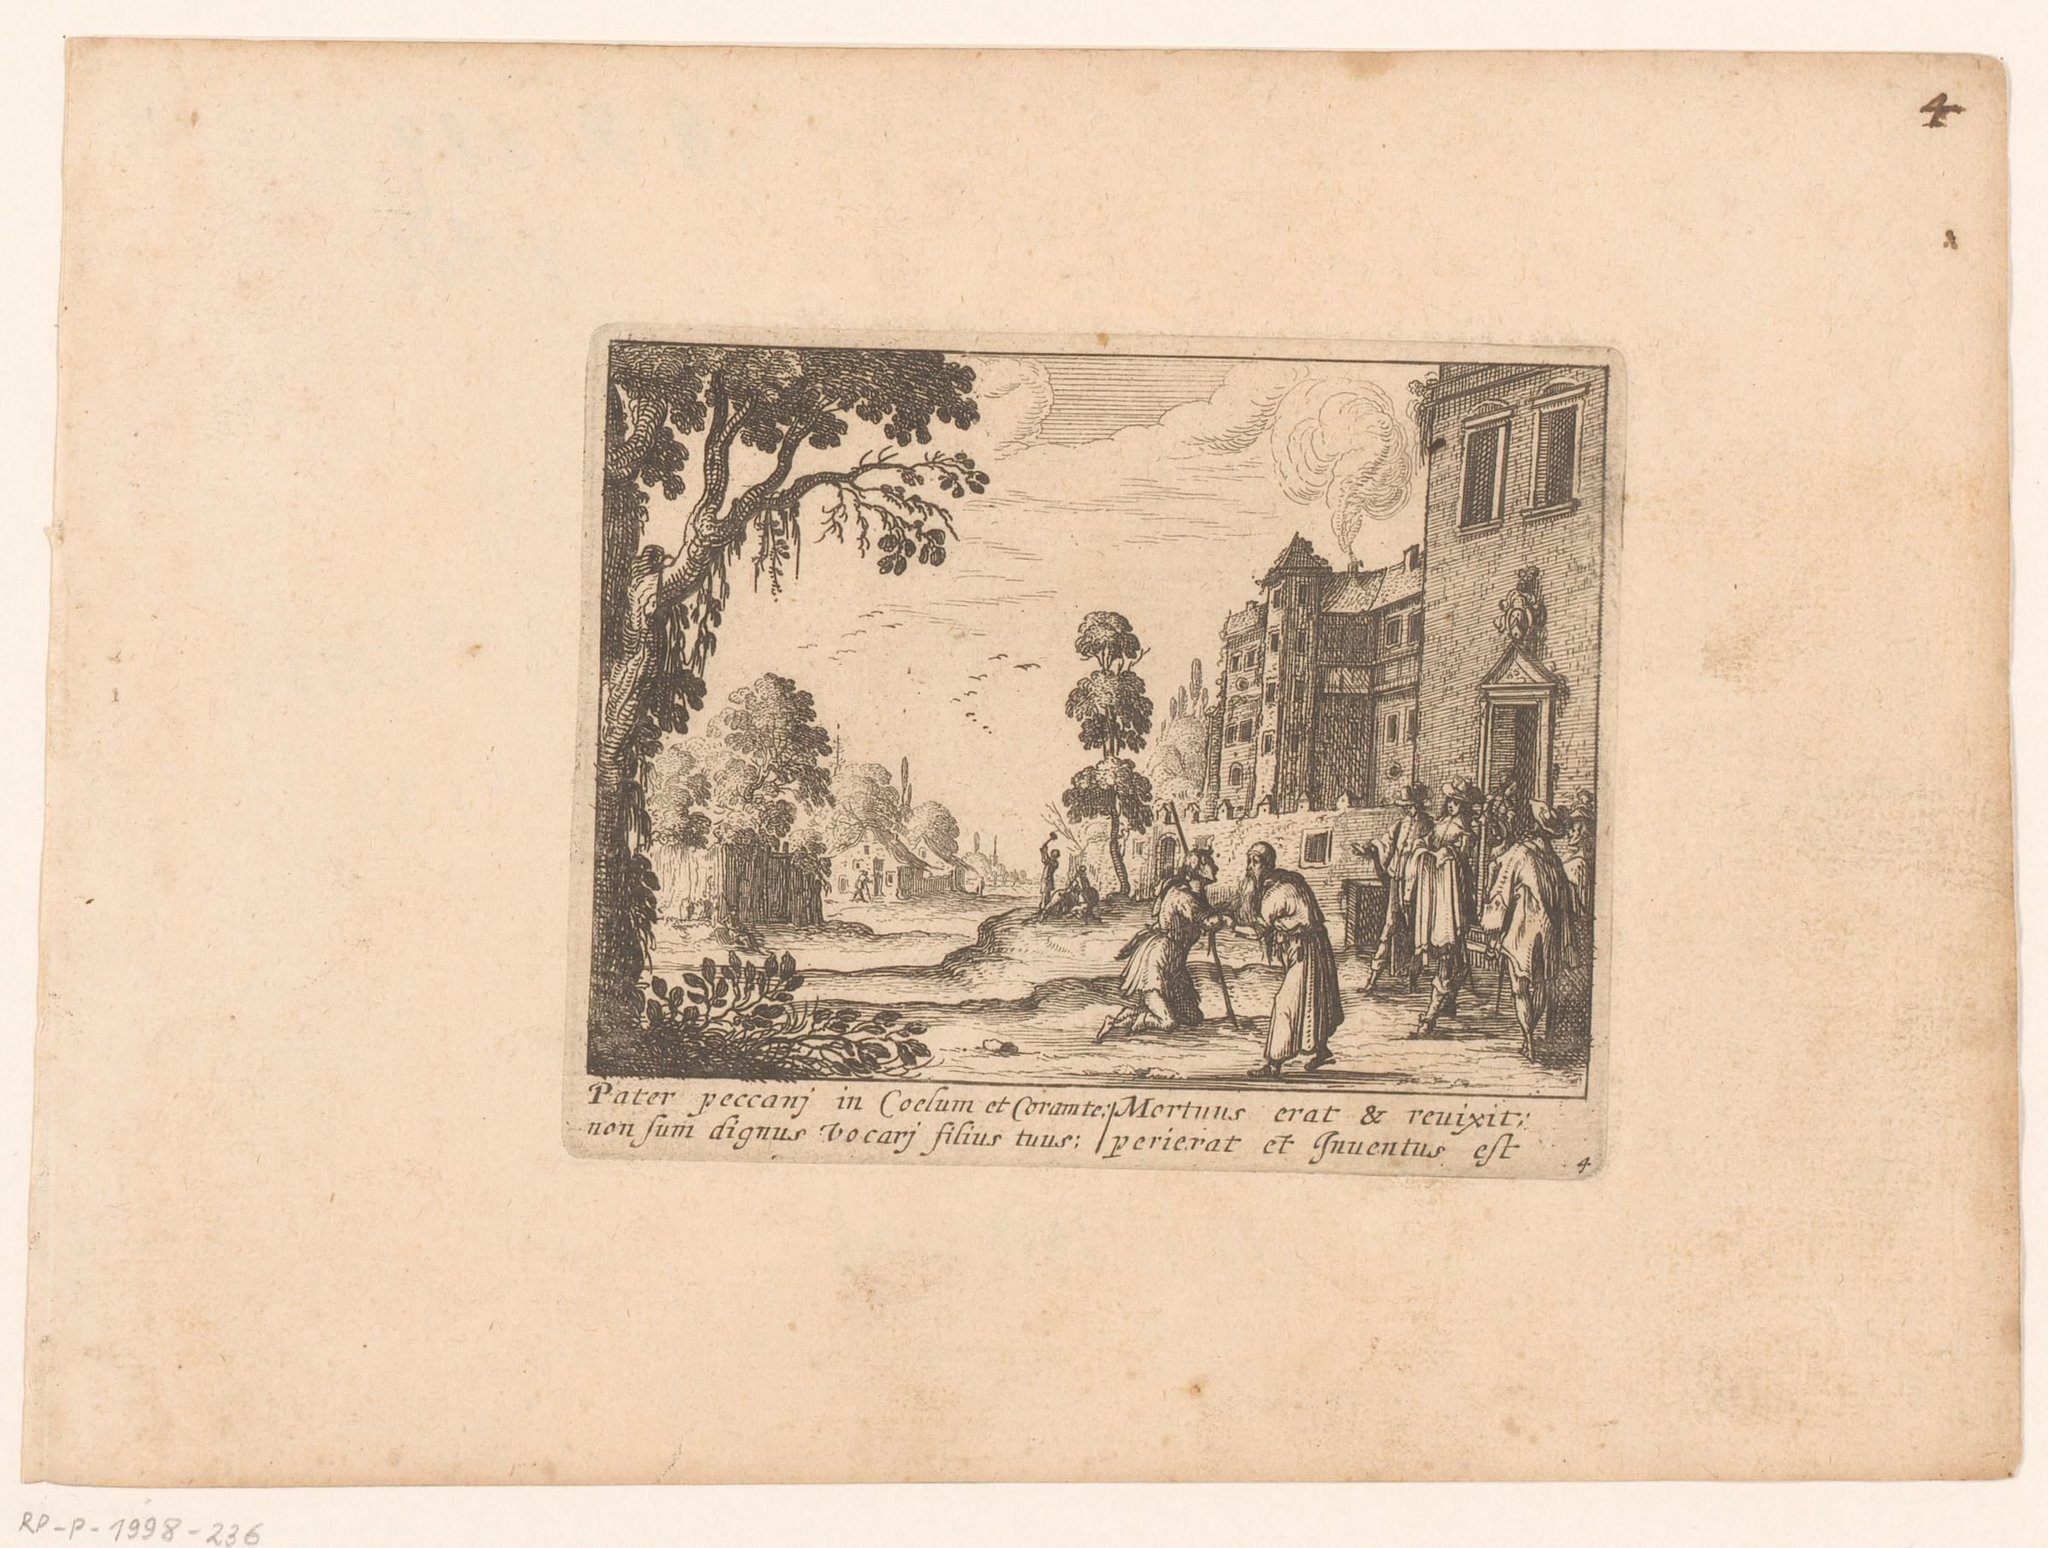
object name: print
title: Thuiskomst van de verloren zoon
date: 1620-1686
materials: paper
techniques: drypoint, engraving, etching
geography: france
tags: the prodigal son returns home, where his father awaits him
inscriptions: watermark, inscription: ‘4’, collector's mark: Lugt 2228